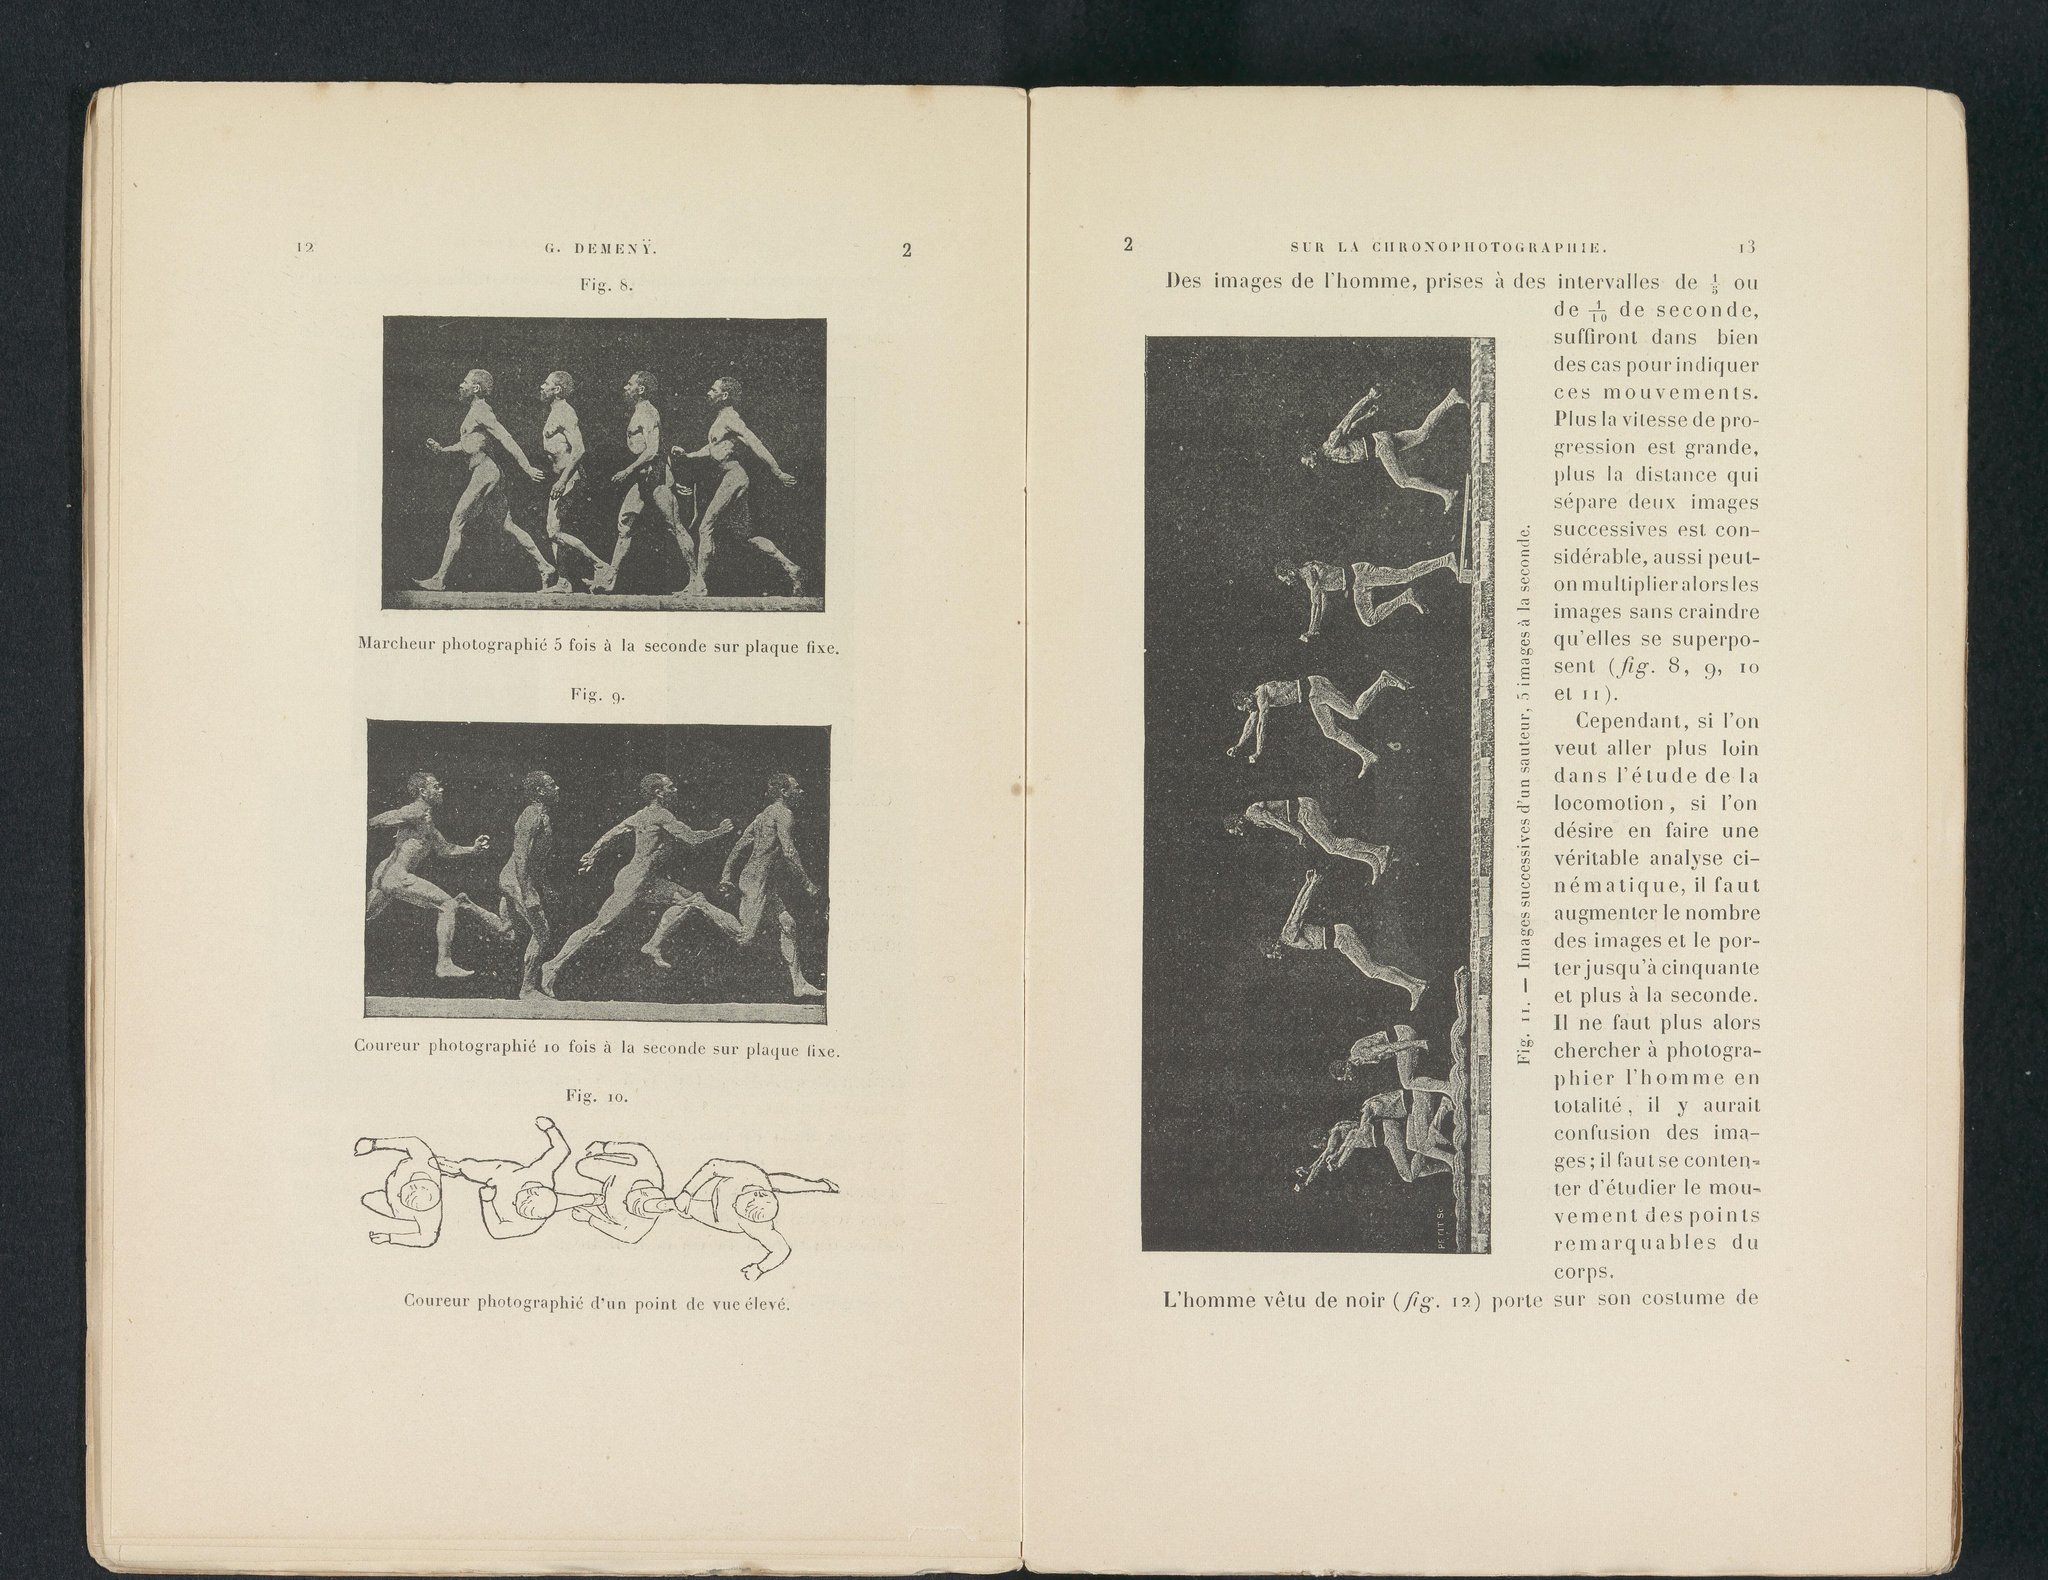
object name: page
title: Lopende man en springende man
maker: Anonymous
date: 1870-1890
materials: paper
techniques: autotype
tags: jumping up, walking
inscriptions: inscription: ‘Marcheur photographié (...) plaque fixe.’, number: ‘Fig. 8. (...) Fig. 9.’